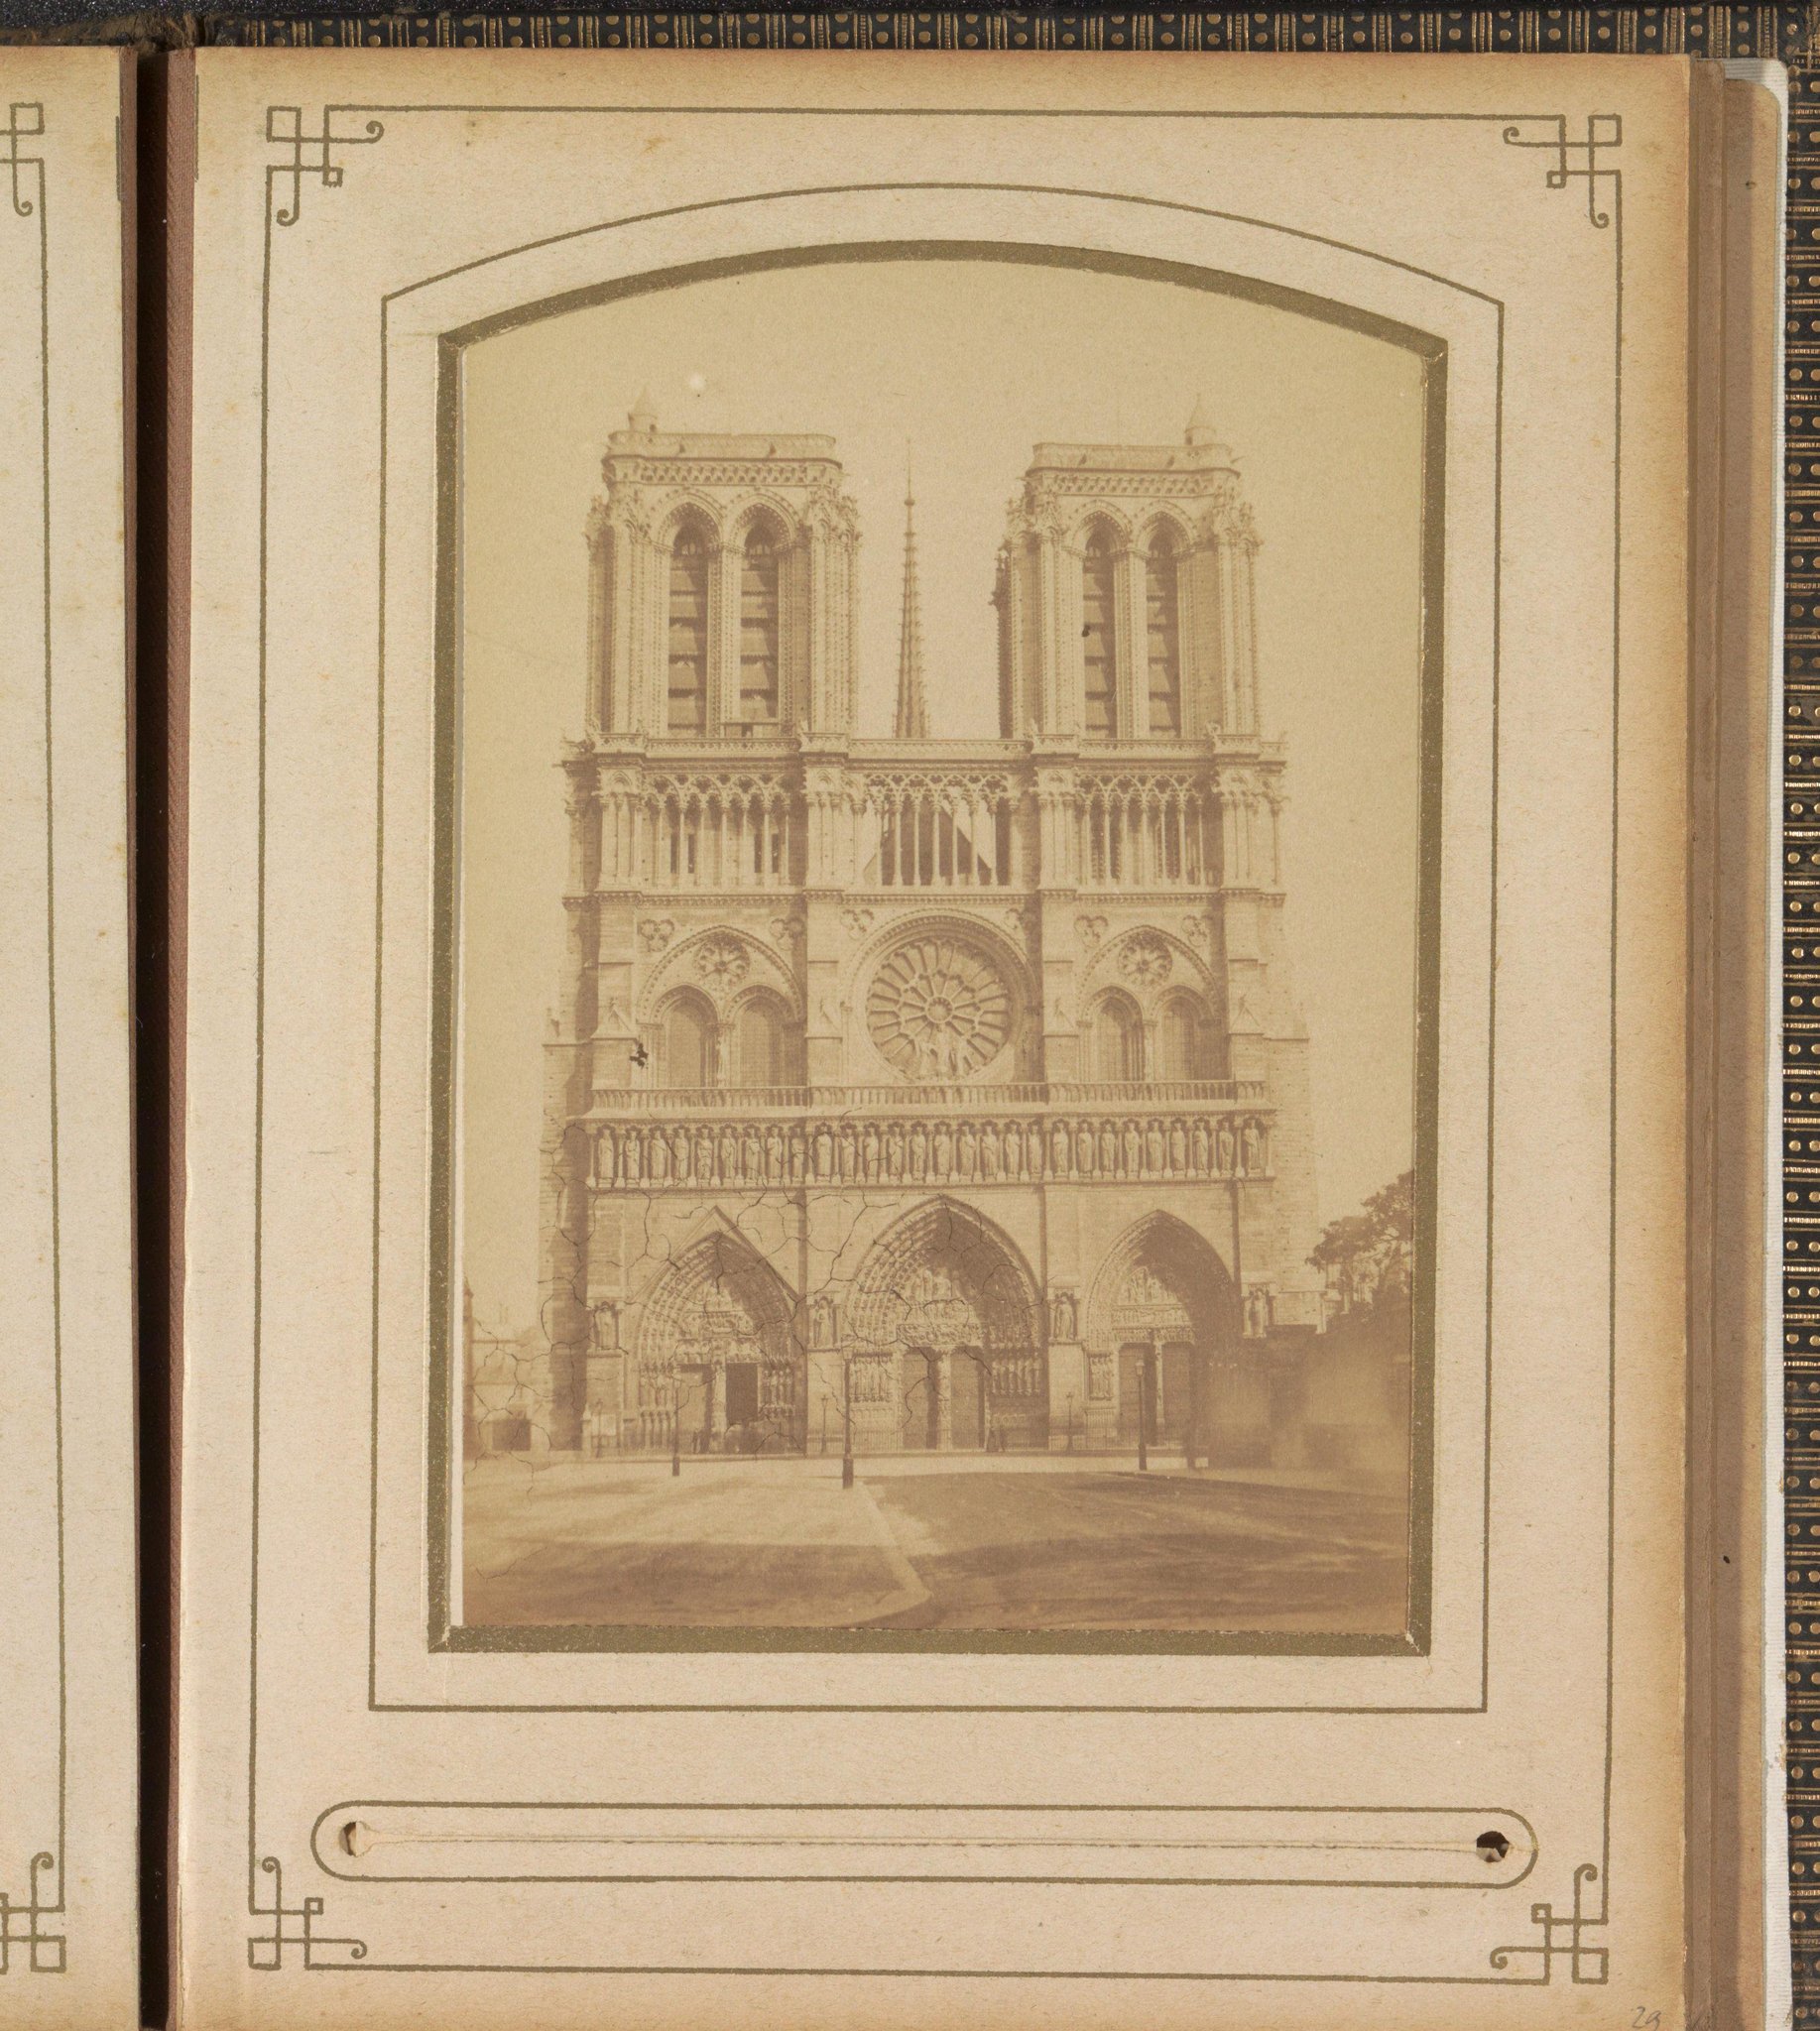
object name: cabinet photograph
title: Exterieur van de Notre-Dame in Parijs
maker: Anonymous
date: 1870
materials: cardboard, paper, photographic support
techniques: albumen print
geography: paris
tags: church (exterior), parts of church exterior and annexes: tower, paris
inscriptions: inscription: ‘Notre-Dame Parijs’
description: Onderdeel van Fotoalbum met kabinetfoto's van bezienswaardigheden in Parijs.